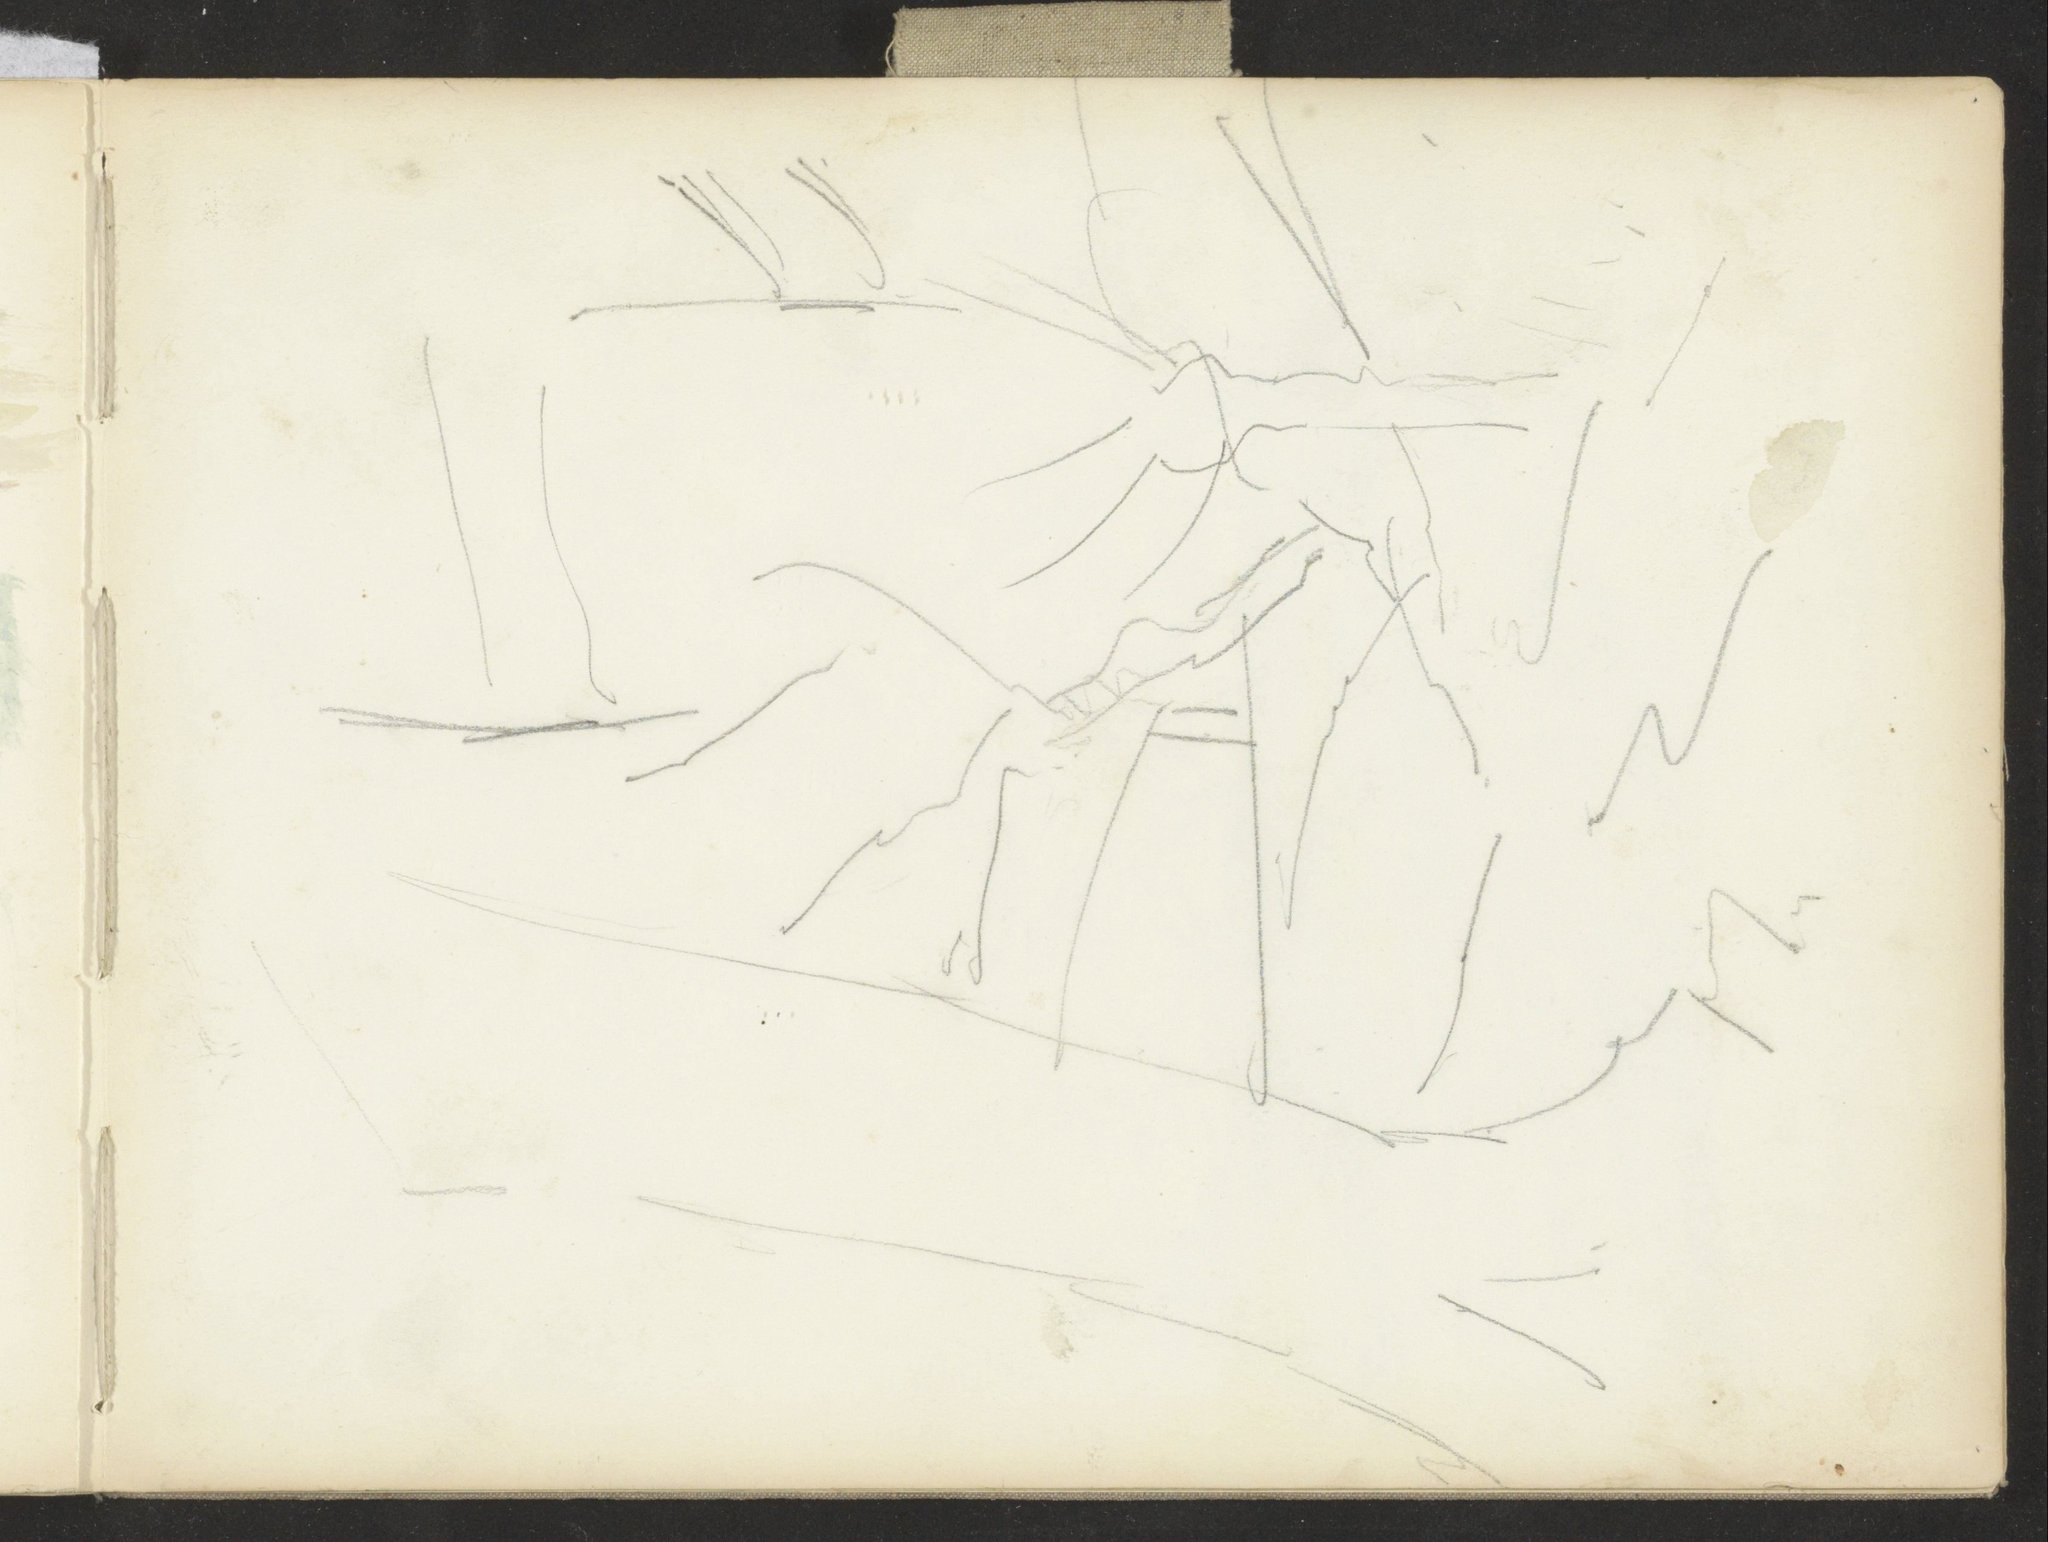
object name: sketchbook leaf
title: Bomen langs een waterkant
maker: jonkheer johannes ludovicus paulus bosch van drakestein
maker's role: draughtsman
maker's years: 1865-1929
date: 1913-1916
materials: paper, pencil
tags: trees, landscapes with waters, waterscapes, seascapes (in the temperate zone)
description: Blad 45 recto uit een schetsboek met 47 bladen.